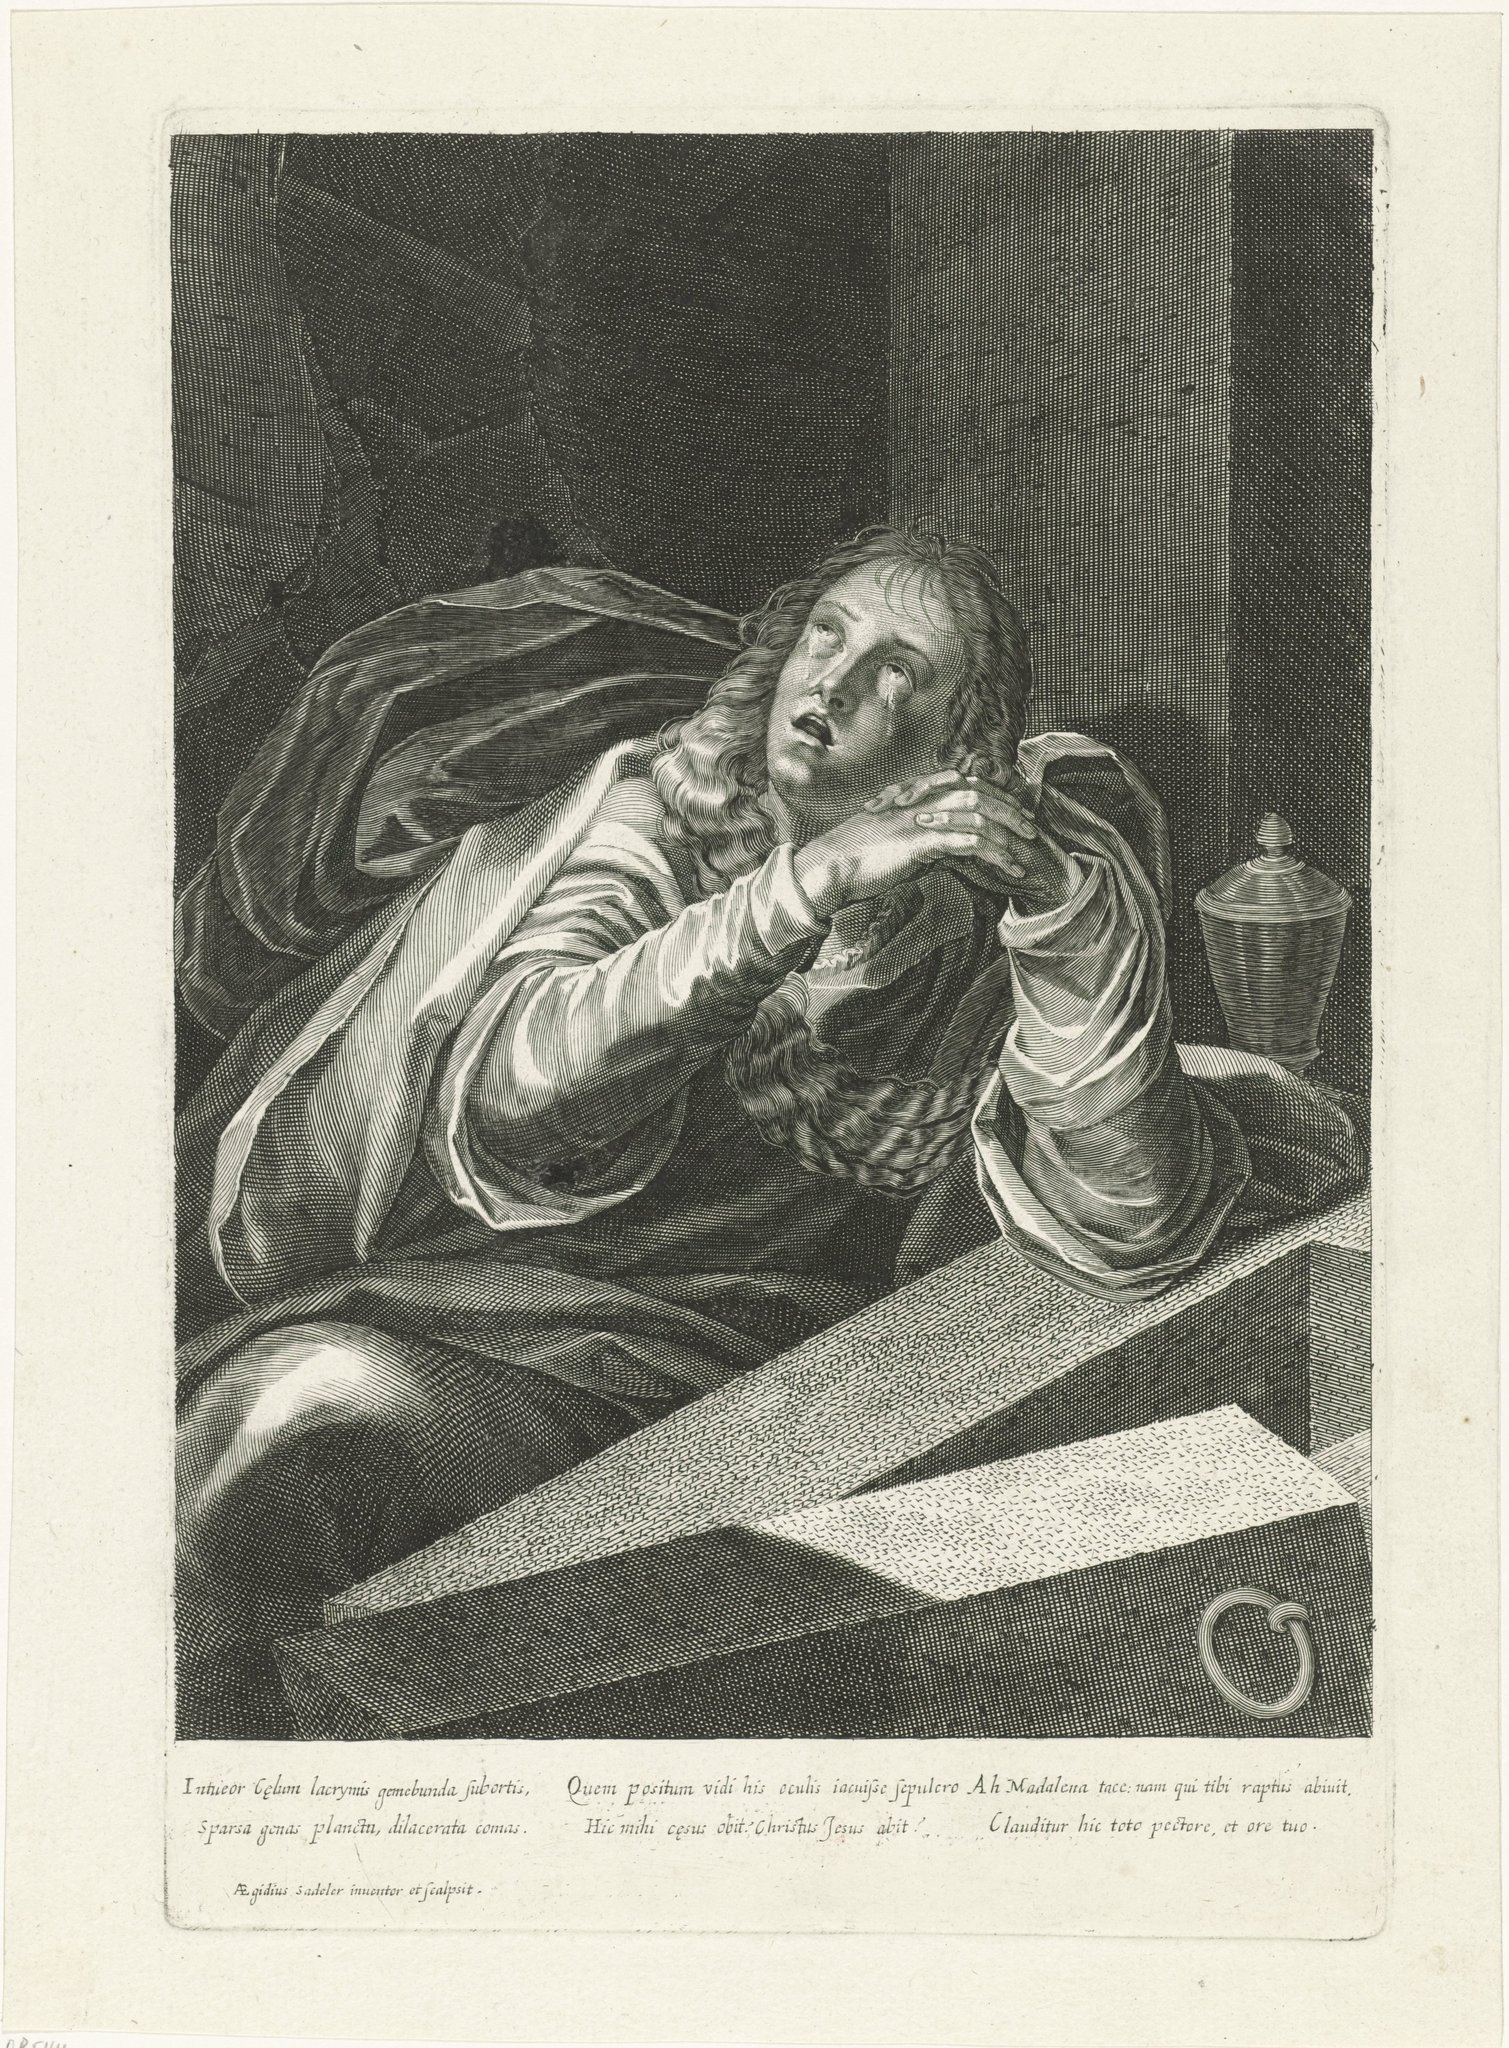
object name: print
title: Maria Magdalena bij het graf van Christus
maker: aegidius sadeler (ii)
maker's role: draughtsman, print maker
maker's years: 1568-1629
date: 1580-1629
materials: paper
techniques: engraving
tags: angel(s) addressing mary magdalene ~ resurrection of christ, the penitent harlot mary magdalene; possible attributes: book (or scroll), crown, crown of thorns, crucifix, jar of ointment, mirror, musical instrument, palm-branch, rosary, scourge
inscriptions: collector's mark: Lugt 240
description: Maria Magdalena, wenend bij het open graf van Christus. Haar zalfpot rechts achter haar. De prent heeft een Latijns onderschrift.